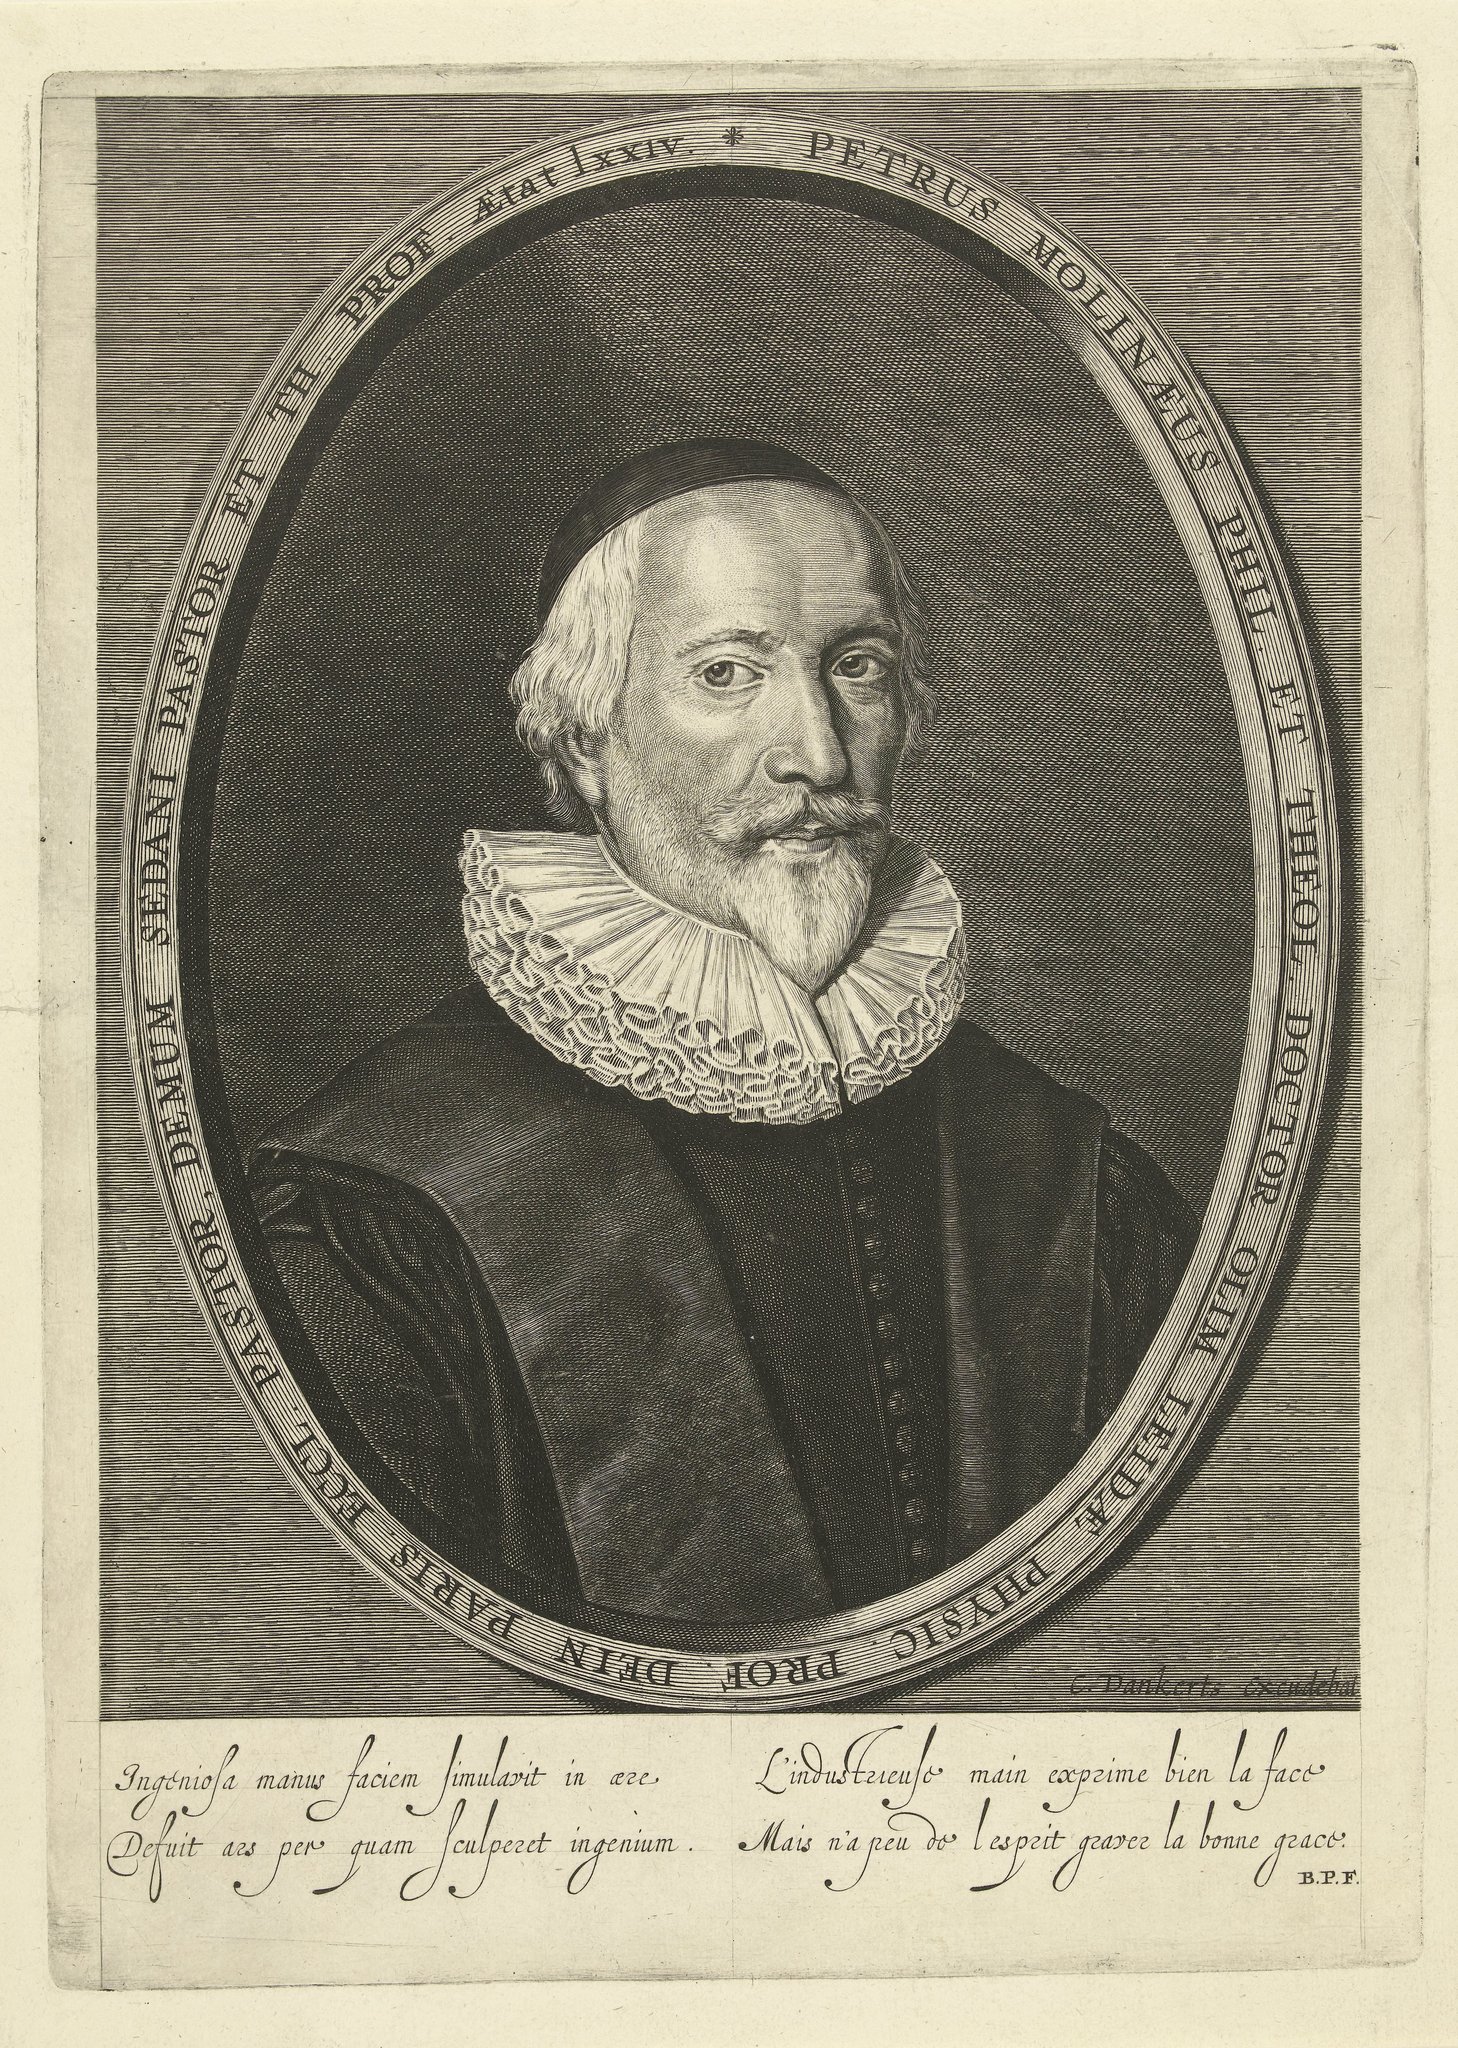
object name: print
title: Portret van Pierre du Moulin op 74-jarige leeftijd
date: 1632-1665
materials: paper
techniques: engraving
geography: amsterdam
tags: sedan, minister, theoloog, pierre du moulin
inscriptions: collector's mark: Lugt 2228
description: Portret van Pierre du Moulin, gekleed in toga met plooikraag. Borststuk in ovale omlijsting. In marge onder vers in Latijn.